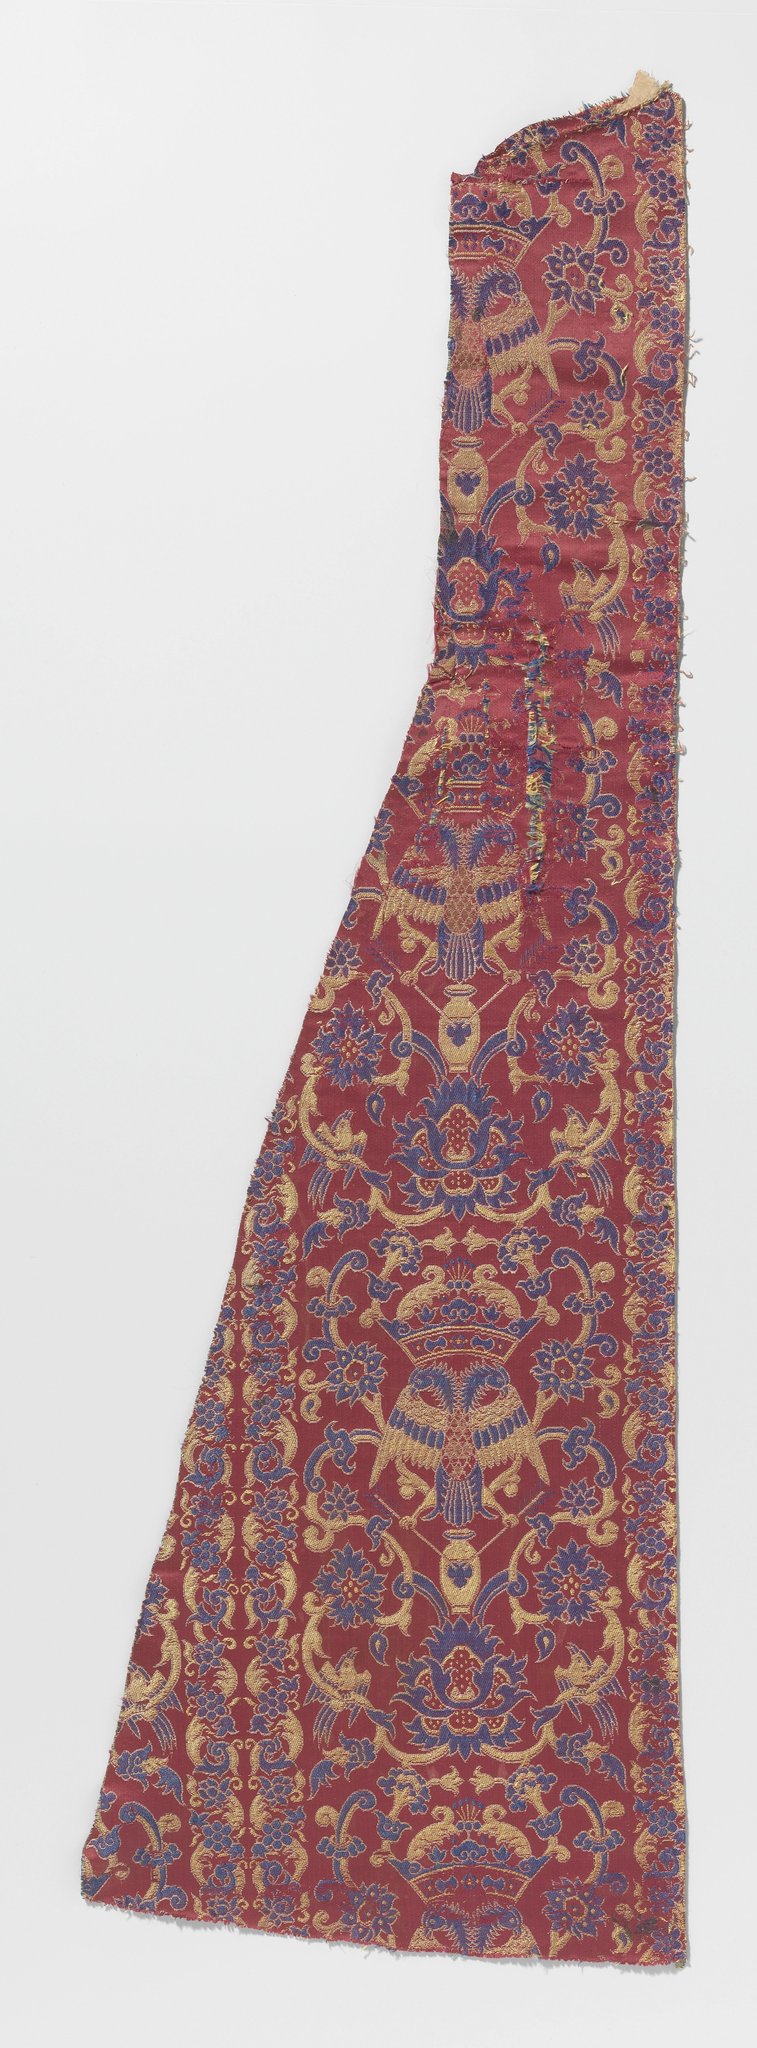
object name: zijdesatijn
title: Fragment of silk fabric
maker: Anonymous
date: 1580-1620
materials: textile, silk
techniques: brocade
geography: macau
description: In 1557 the Chinese authorities gave the Portuguese permission to establish themselves on Macau, an island in the estuary of the Pearl River in southeast China. For centuries this was the only European settlement on the Chinese mainland. Commissioned luxury goods were made there. The Catholic Order of Saint Augustine in Spain and Portugal used the motif of a double-headed eagle. They ordered this fabric for their vestments, and other accessories.